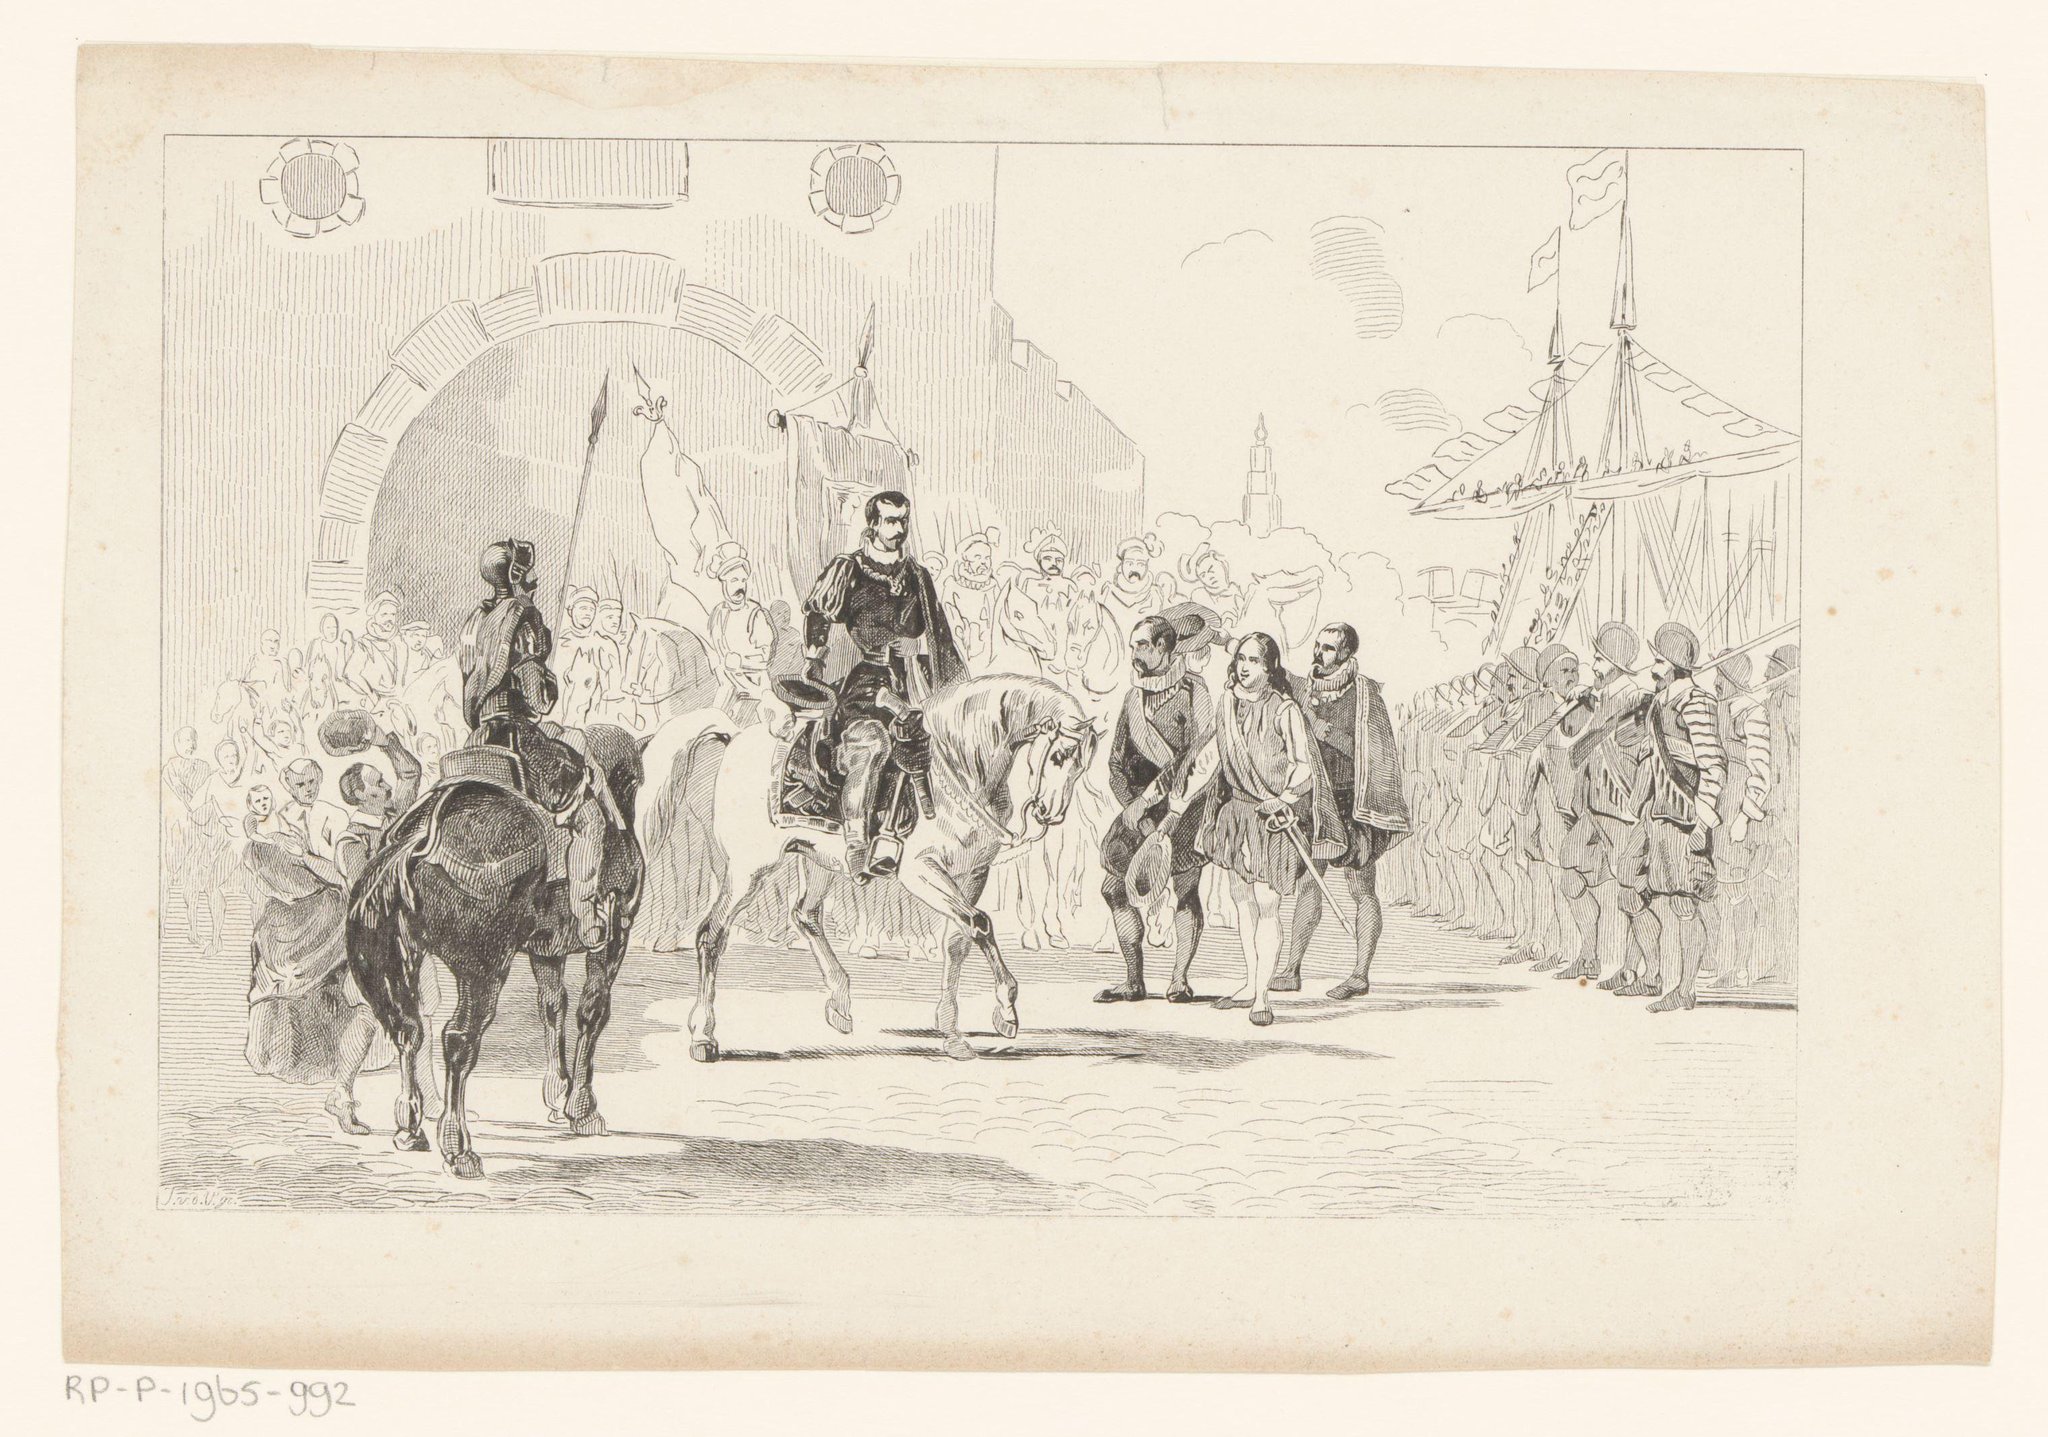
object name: print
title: Intocht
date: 1855-1861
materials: paper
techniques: lithograph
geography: netherlands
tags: triumphal entry and public reception, pageant, 'entrée solennelle', 'joyeuse entrée'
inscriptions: collector's mark: Lugt 2228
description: Proefdruk voor prent uit: Lennep, Jacob van. De geschiedenis des vaderlands in schetsen en afbeeldingen. Amsterdam: Binger & Zonen, M.H., 1855-1861.